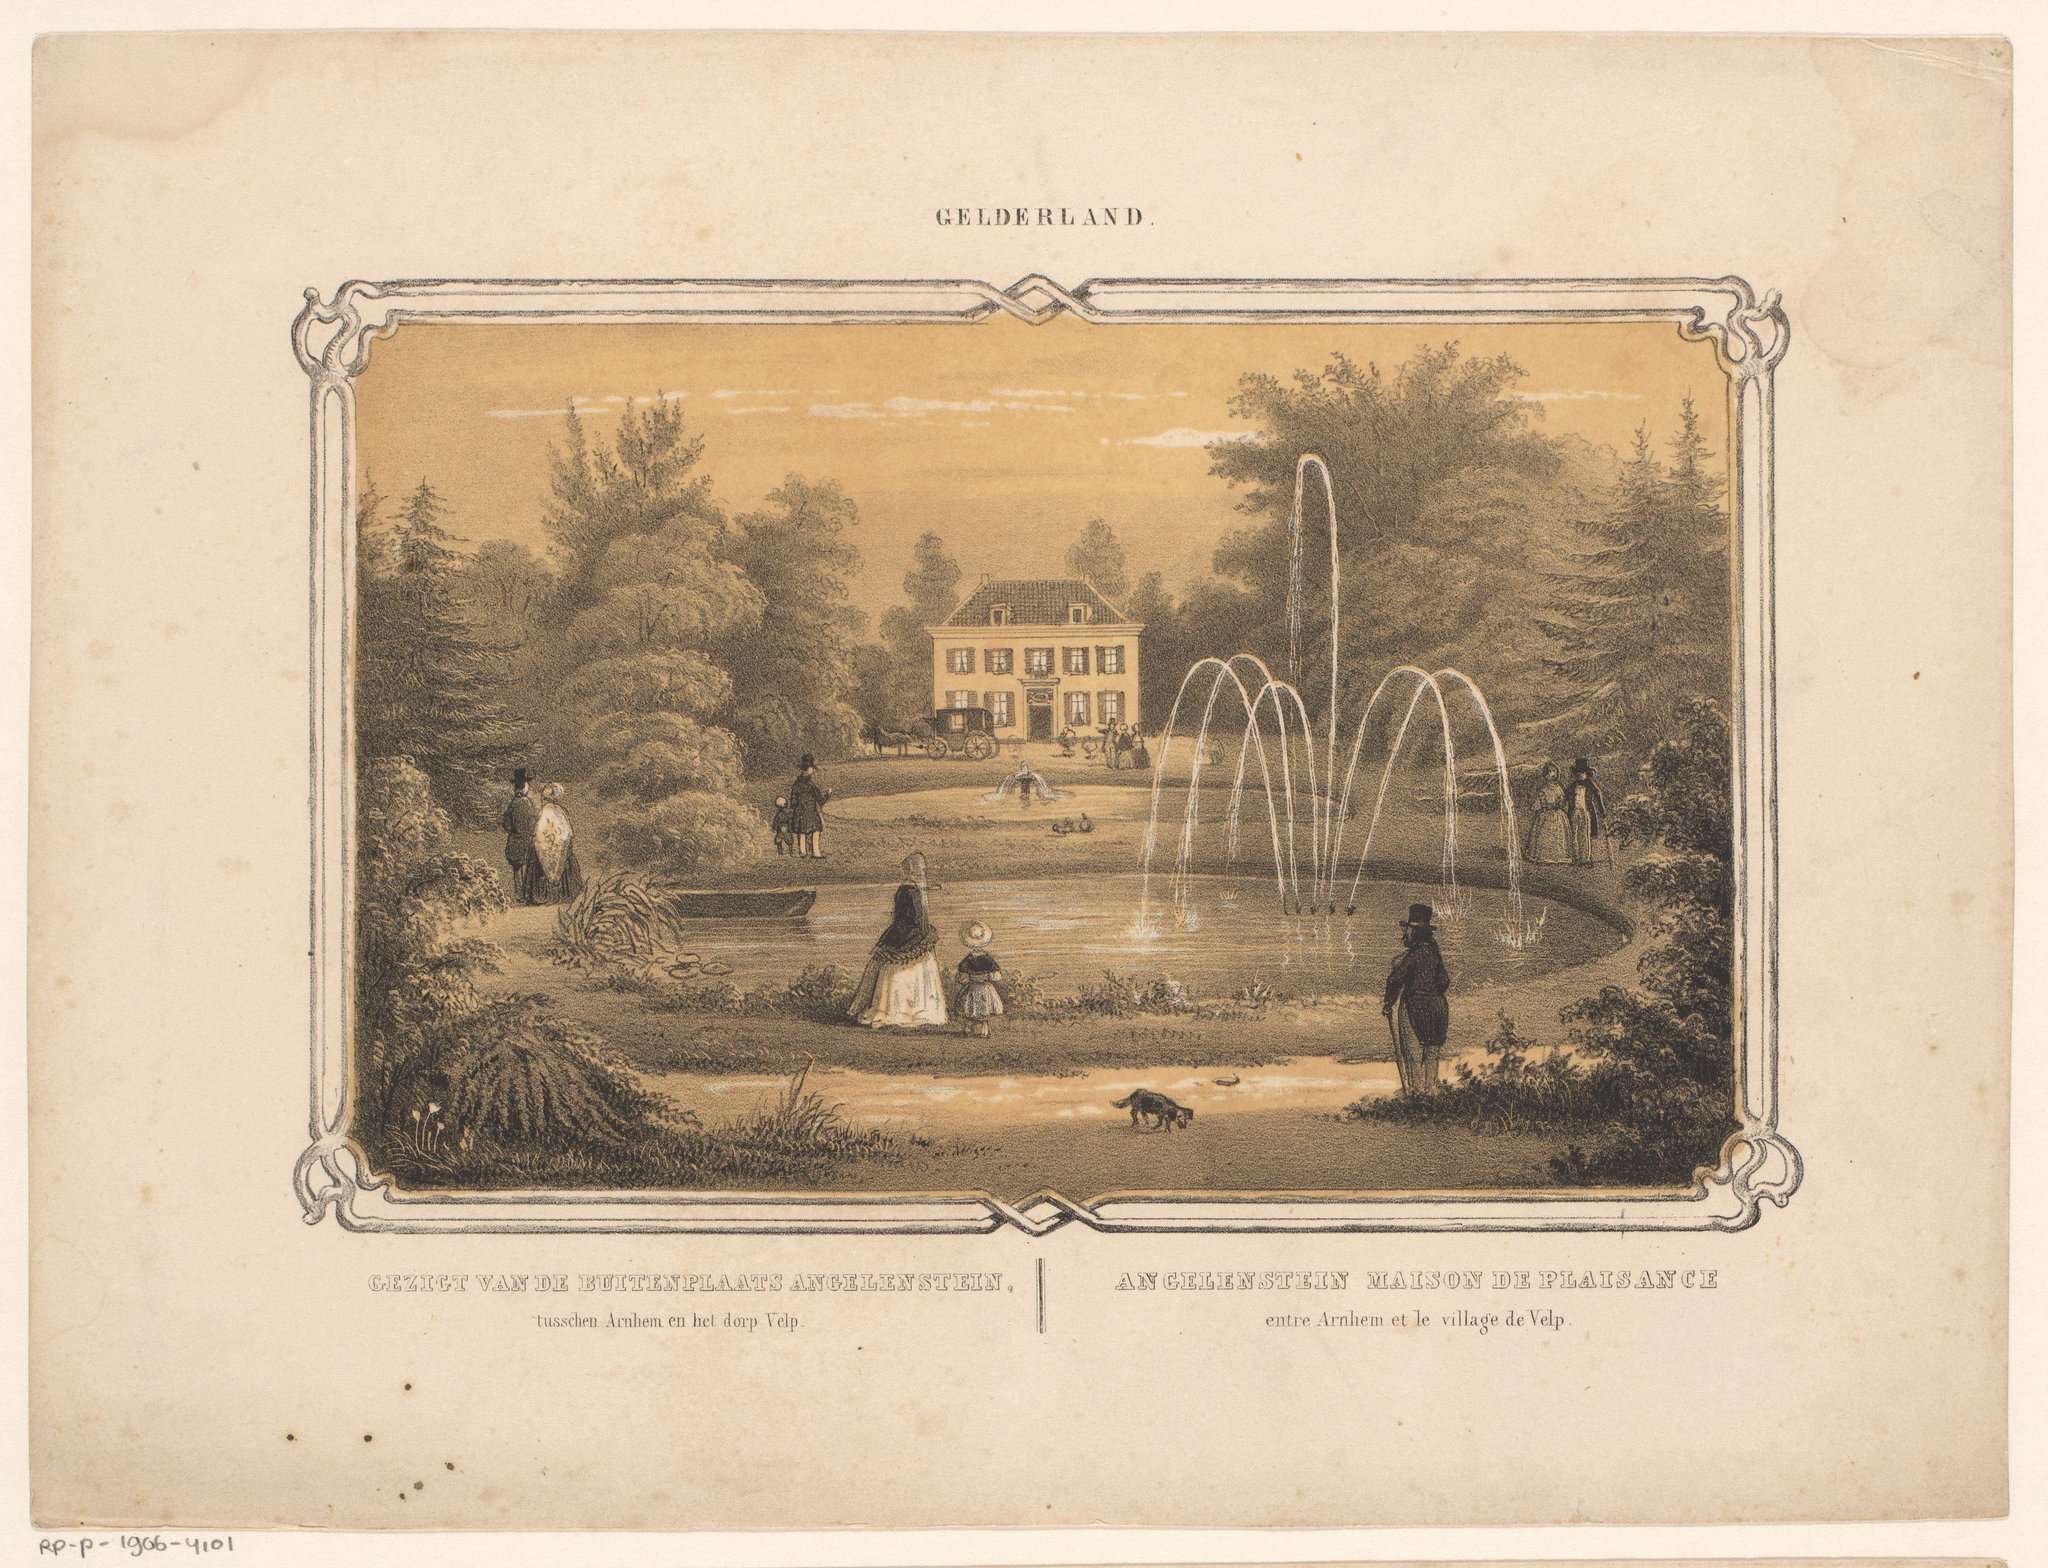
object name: print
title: Gelderland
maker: frederik lodewijk huygens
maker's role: draughtsman, print maker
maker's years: 1802-1887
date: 1812-1887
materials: paper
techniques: tone lithography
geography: netherlands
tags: garden fountain, garden pond, farm or solitary house in landscape, country-house, arnhem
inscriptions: collector's mark: Lugt 2228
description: Voor het huis liggen twee vijvers. In de voorste vijver spuit een grote fontein water omhoog. Rondom de vijvers wandelen figuren.